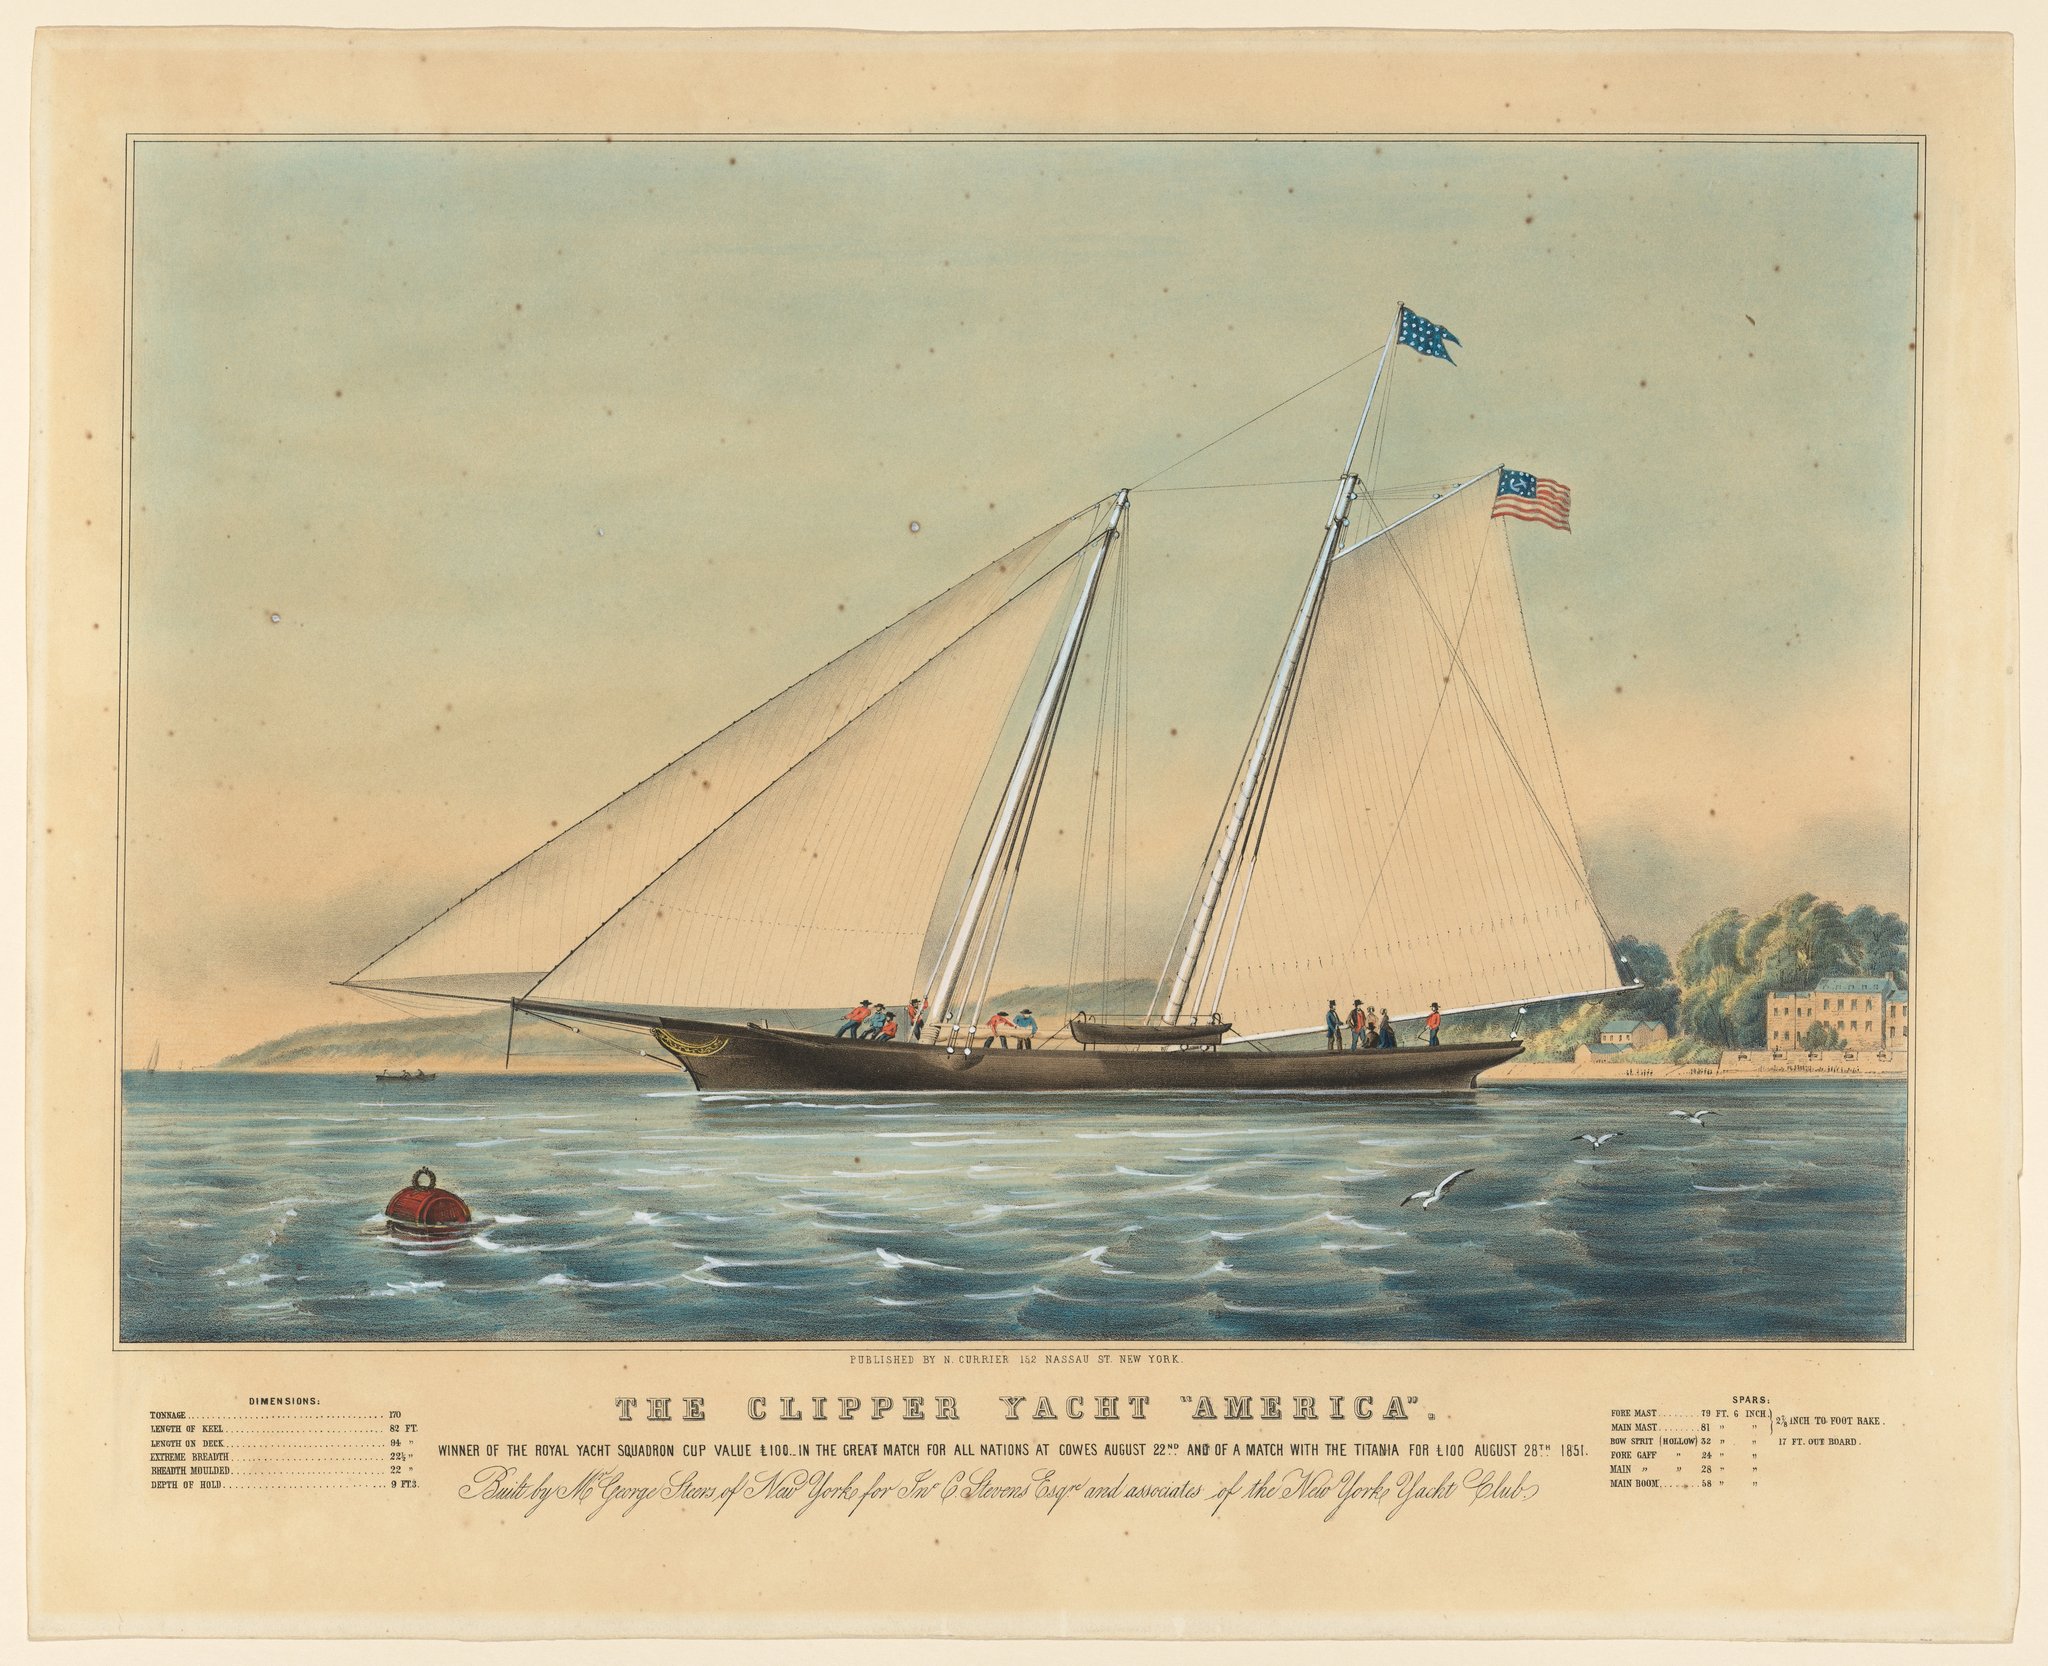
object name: print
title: The Clipper Yacht "America," Winner of the Royal Yacht Squadron Cup, Value £100 in the Great Match for All Nations at Cowes, August 22nd, and of a Match with the Titania for £100, August 28, 1851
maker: nathaniel currier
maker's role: publisher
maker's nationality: american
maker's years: 1813-1888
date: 1851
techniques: hand coloring, lithograph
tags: boats